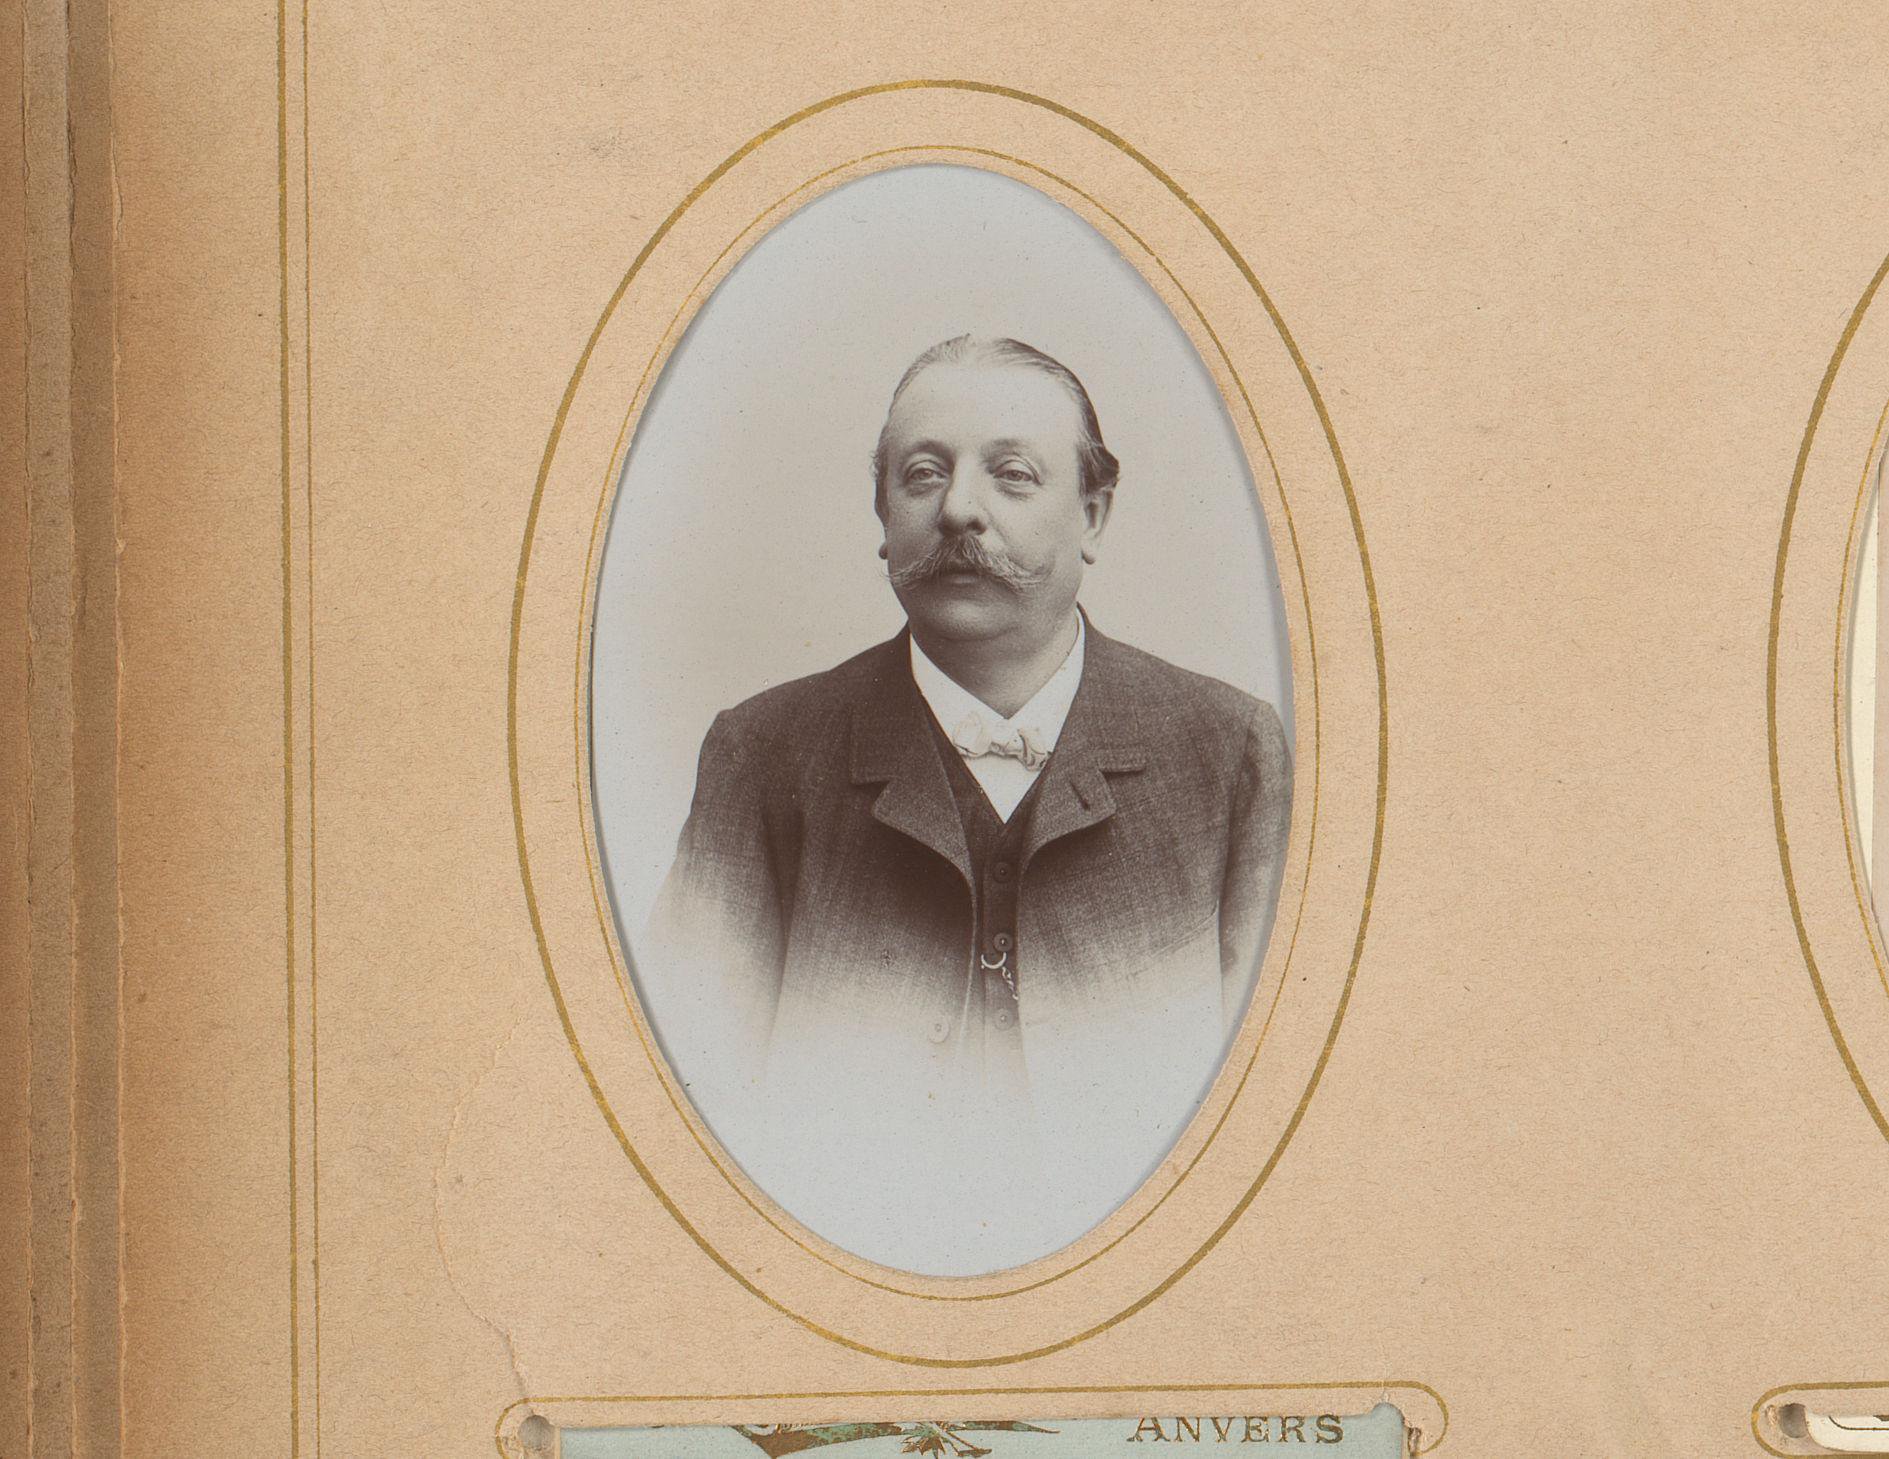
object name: album leaf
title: Portret van een man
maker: j. tobie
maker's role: fotograaf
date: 1905-1914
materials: cardboard, photographic support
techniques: collodion silver print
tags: adult man, historical persons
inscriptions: name: ‘J. Tobie 26 Canal au Sucre/ Anvers’, inscription: ‘Potographie/ J. Tobie/26 Canal au Sucre/ Anvers’